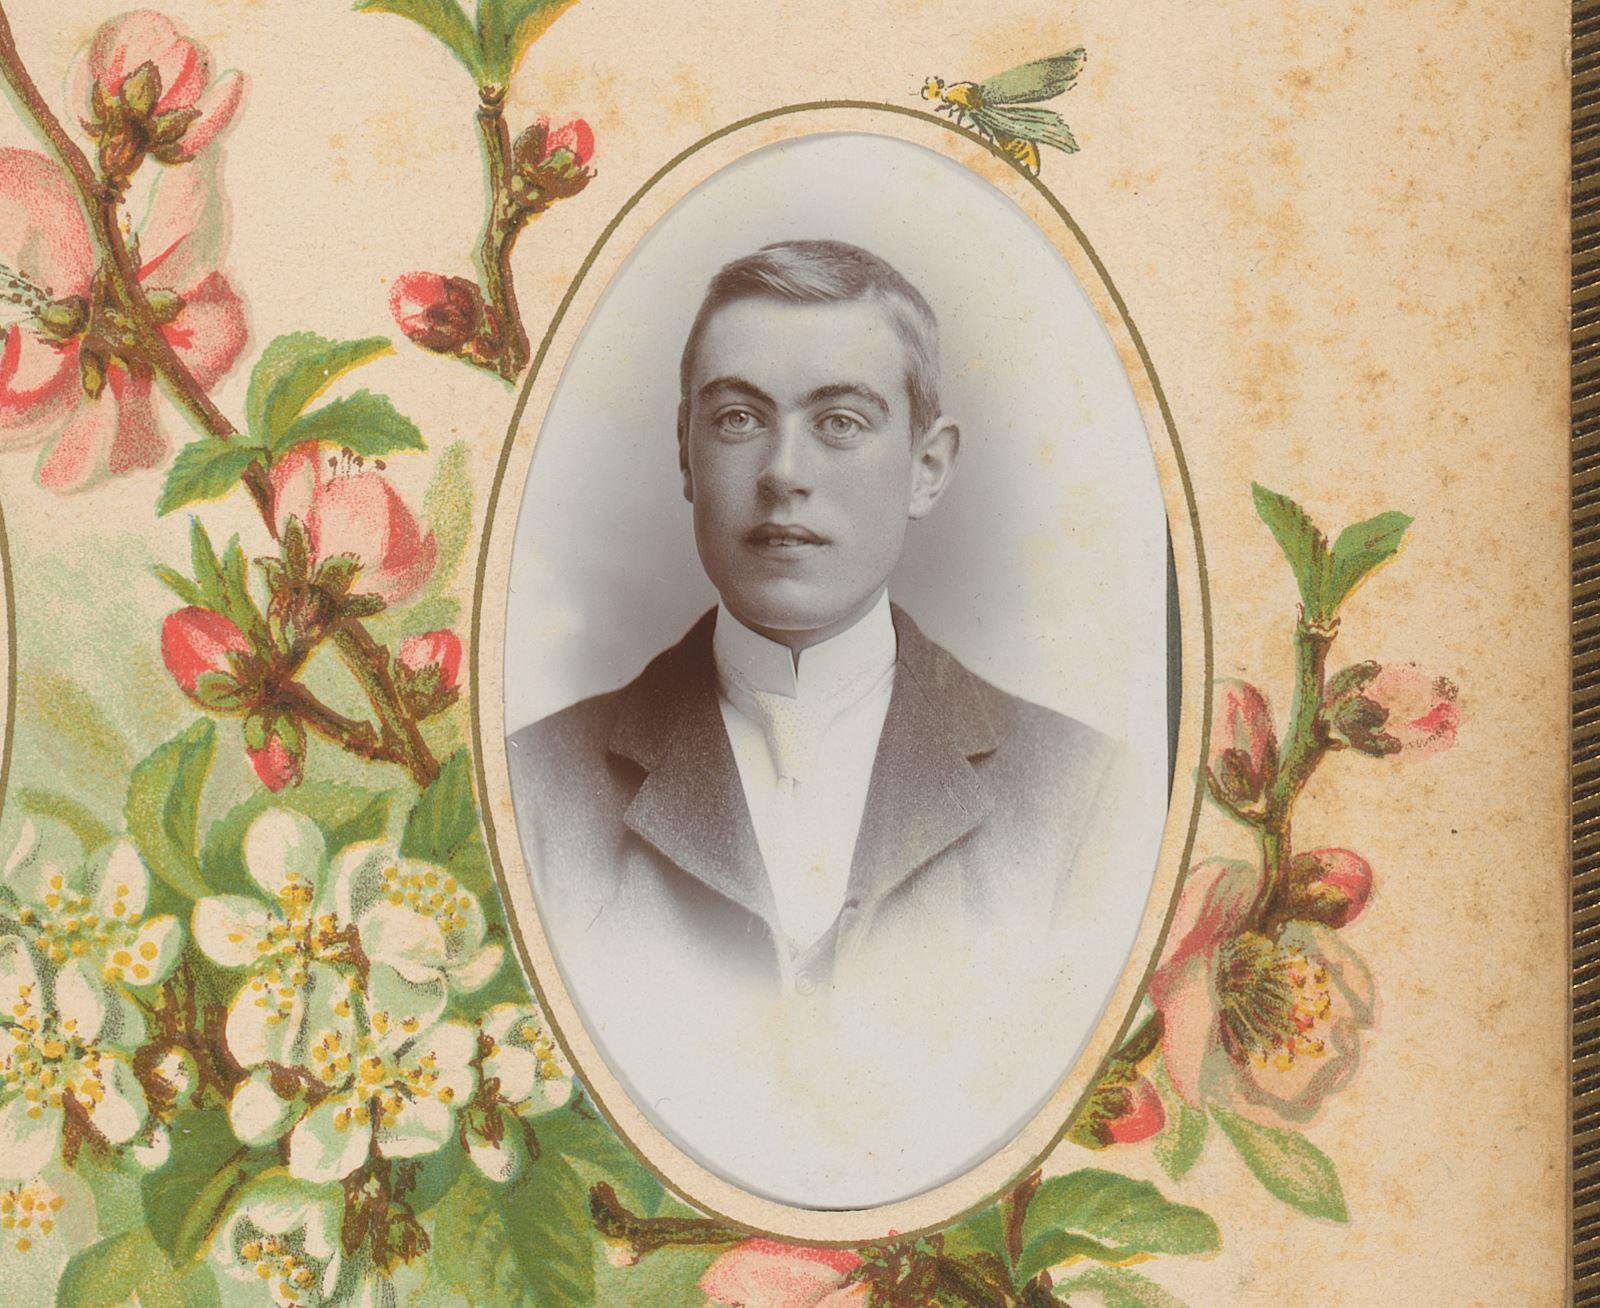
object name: photograph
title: Portret van een jongeman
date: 1880-1910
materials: cardboard, photographic support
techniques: collodion silver print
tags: historical persons, youth, adolescent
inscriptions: inscription: ‘Lowthian Bros 144&146 Freeman St/ Grimsby’